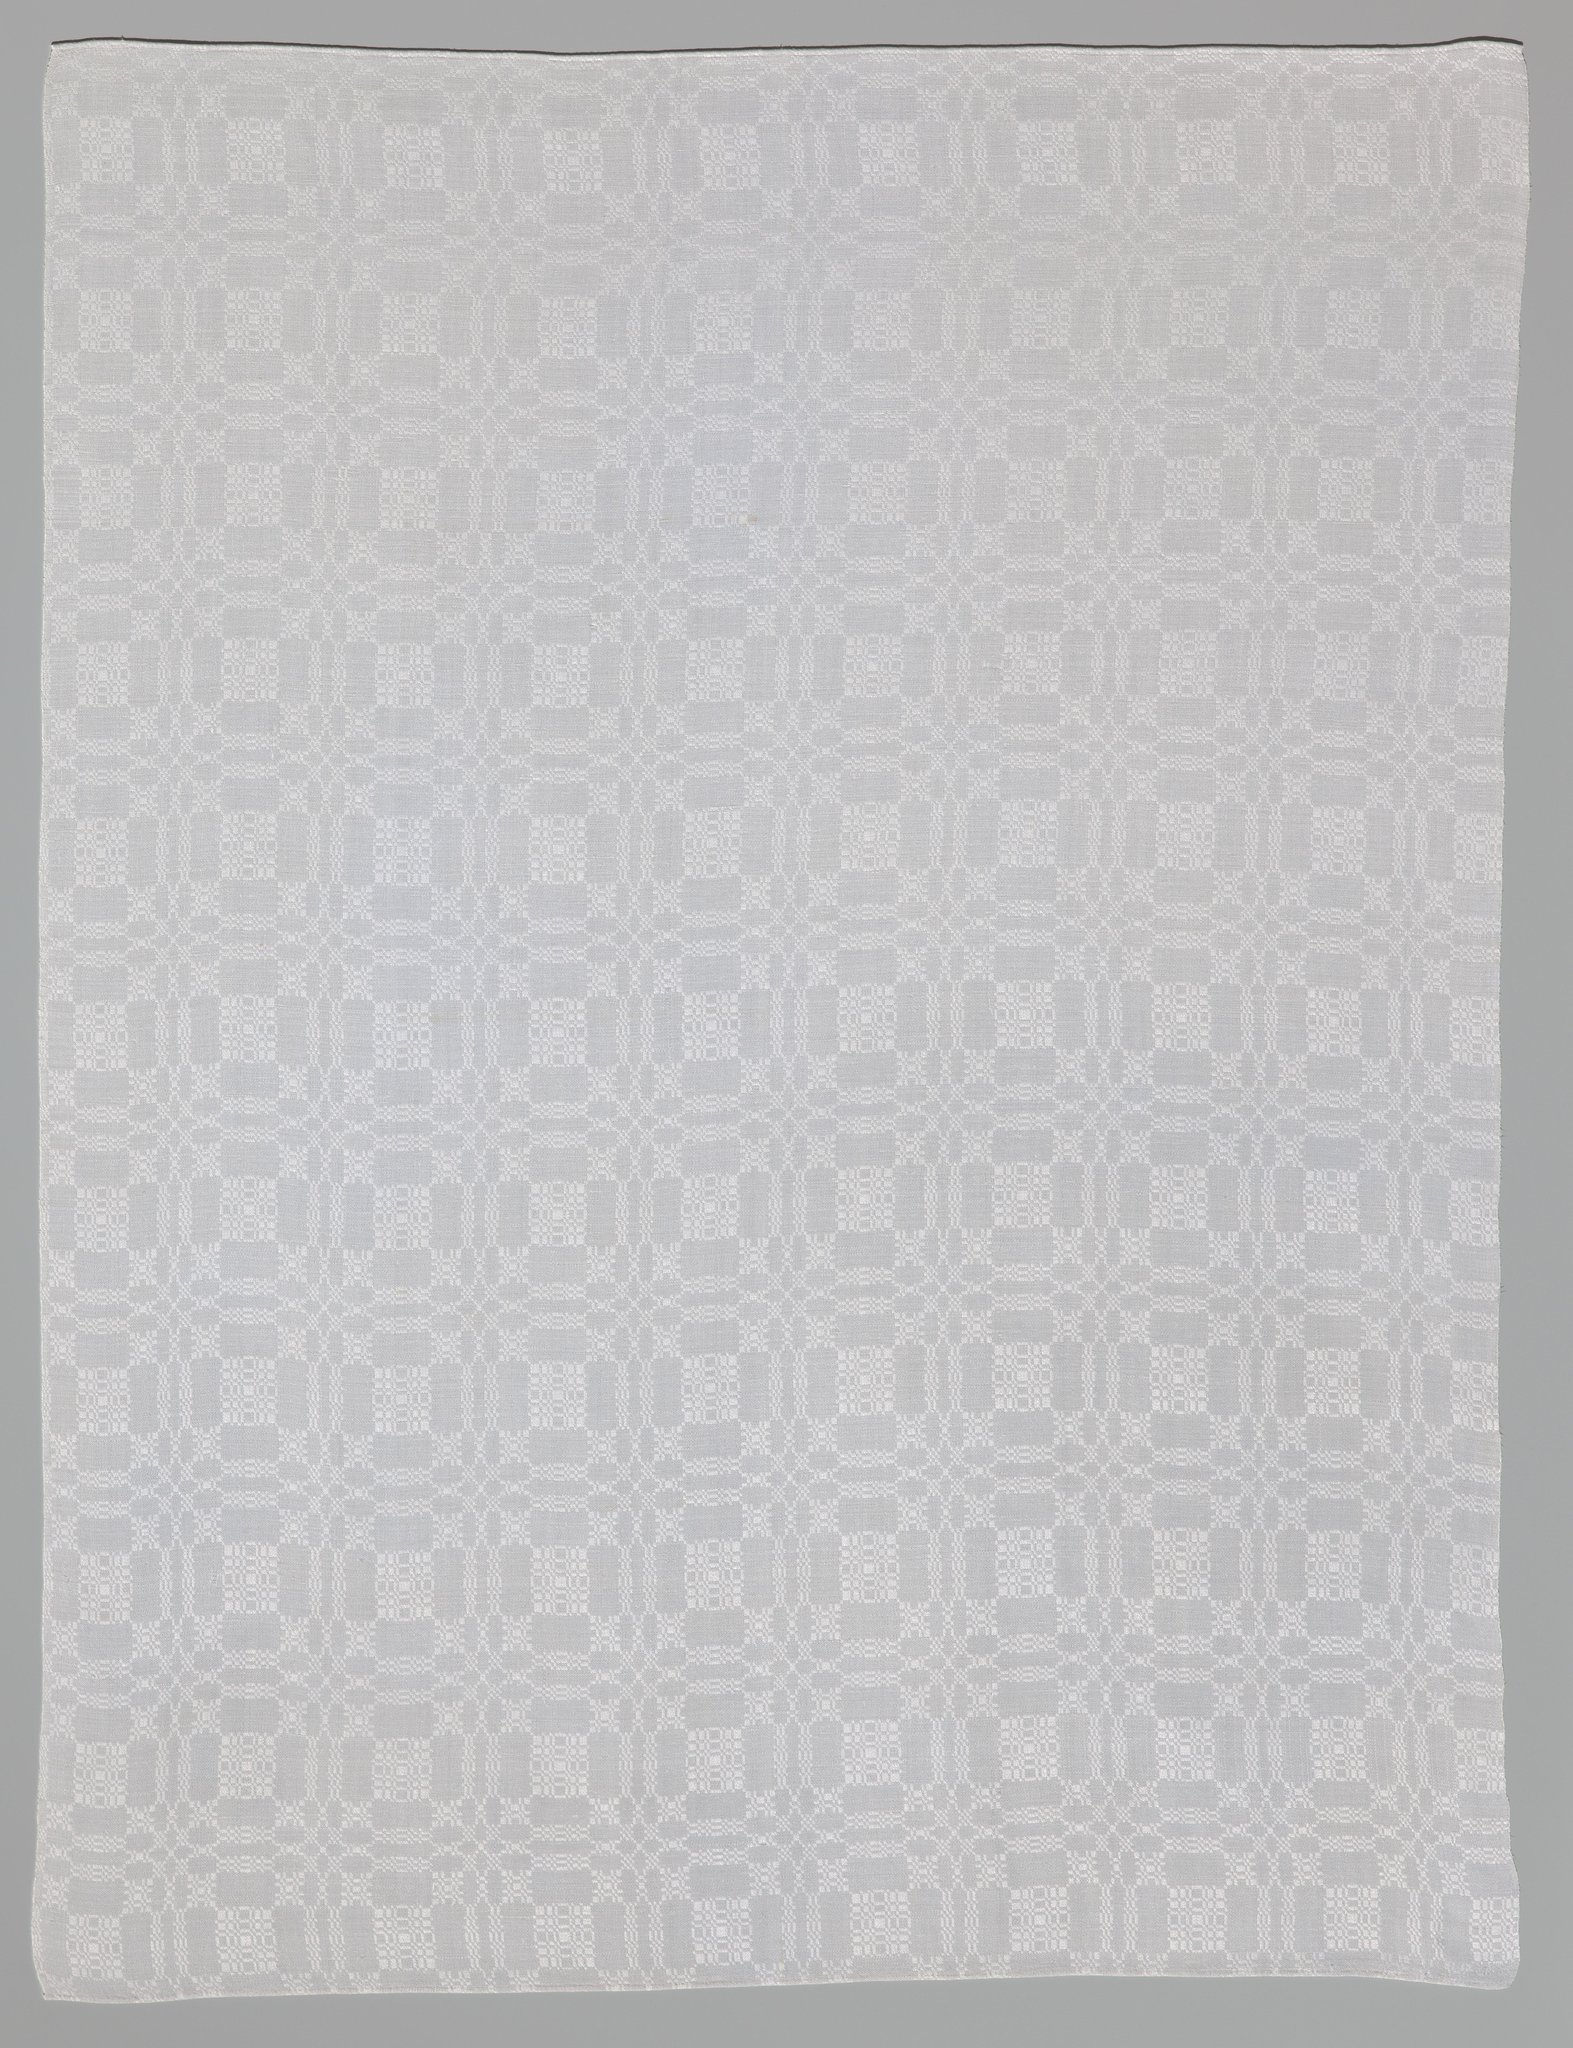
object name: napkin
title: Wit linnen pellen servet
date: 1700-1750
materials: linen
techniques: peeled fabric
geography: northern netherlands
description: Wit linnen pellen servet, gemerkt PH en 82.